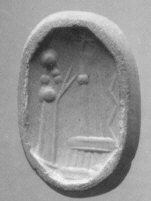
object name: stamp seal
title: Stamp seal (octagonal pyramid) with cultic scene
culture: assyro-babylonian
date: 700-501 BCE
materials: stone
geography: mesopotamia